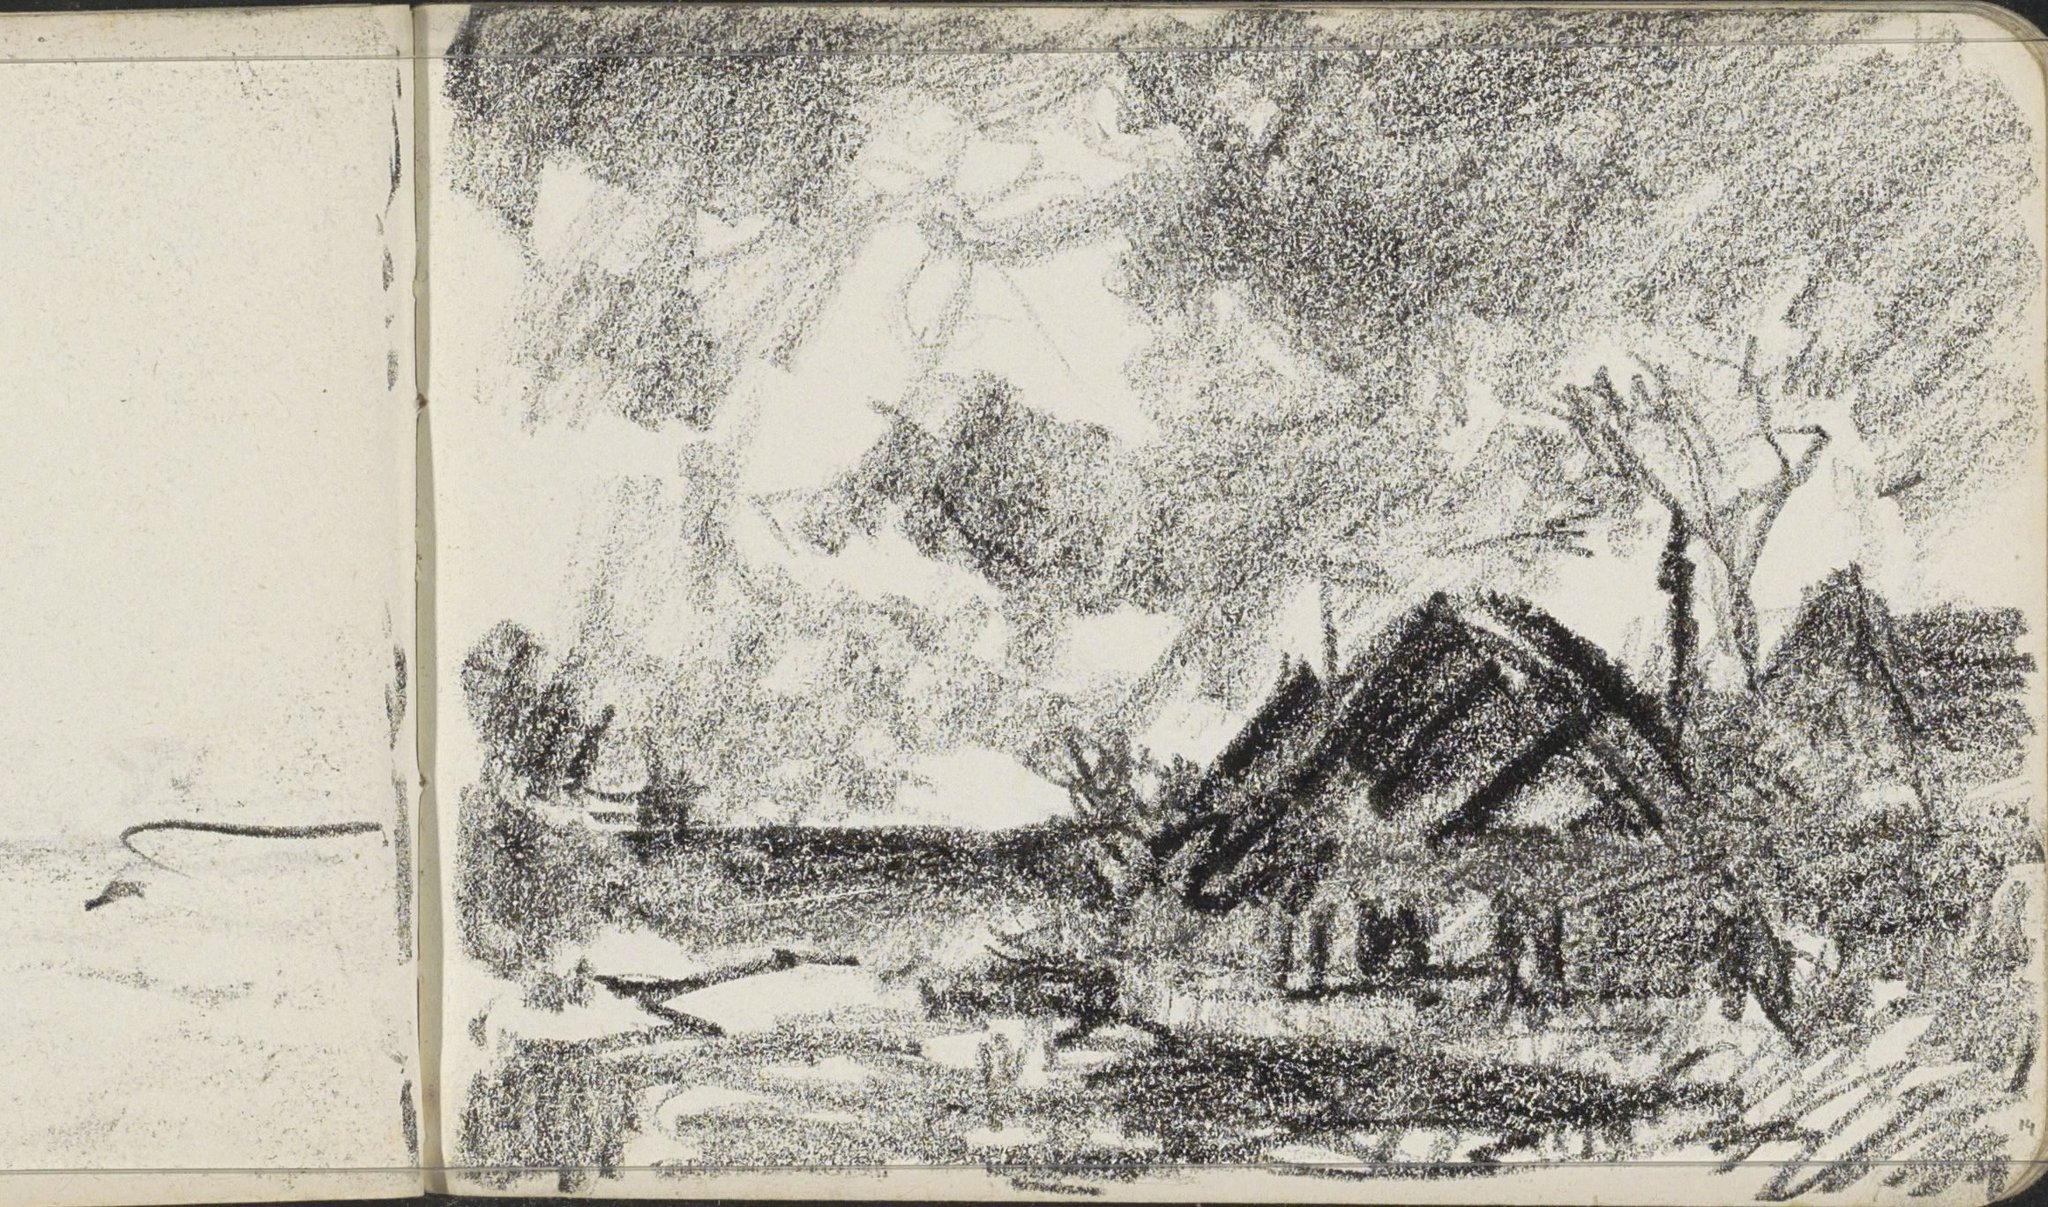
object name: sketchbook leaf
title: Huis in een landschap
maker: willem cornelis rip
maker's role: draughtsman, painter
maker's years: 1856-1922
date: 1907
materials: chalk, paper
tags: farm or solitary house in landscape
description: Blad 14 recto uit een schetsboek met 41 bladen.